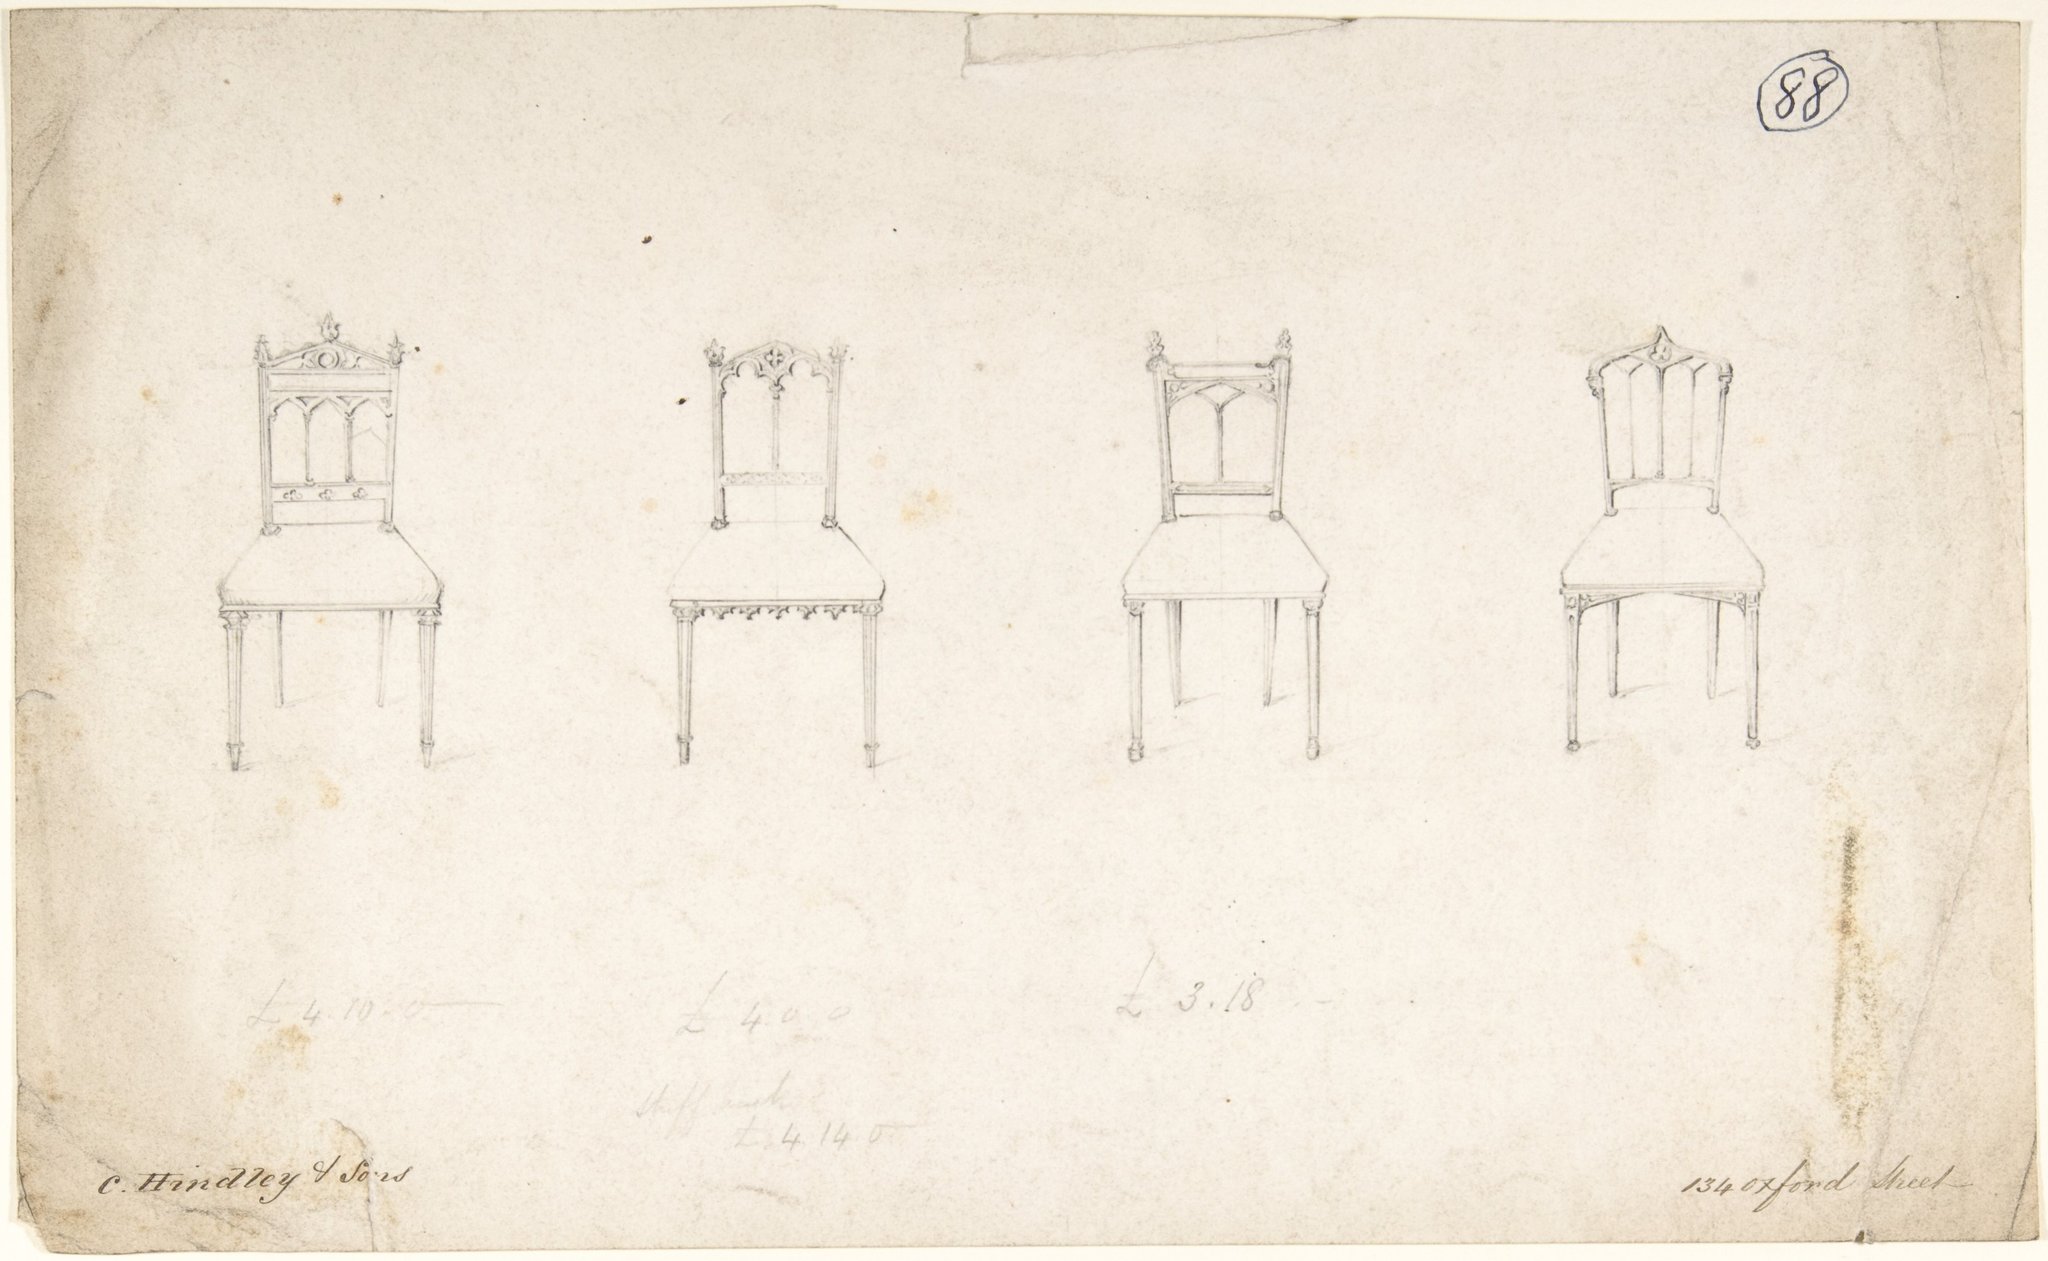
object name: drawing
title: Designs for Four Chairs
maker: charles hindley and sons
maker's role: artist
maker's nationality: british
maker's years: 1841-1917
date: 1841-1884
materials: graphite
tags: chairs